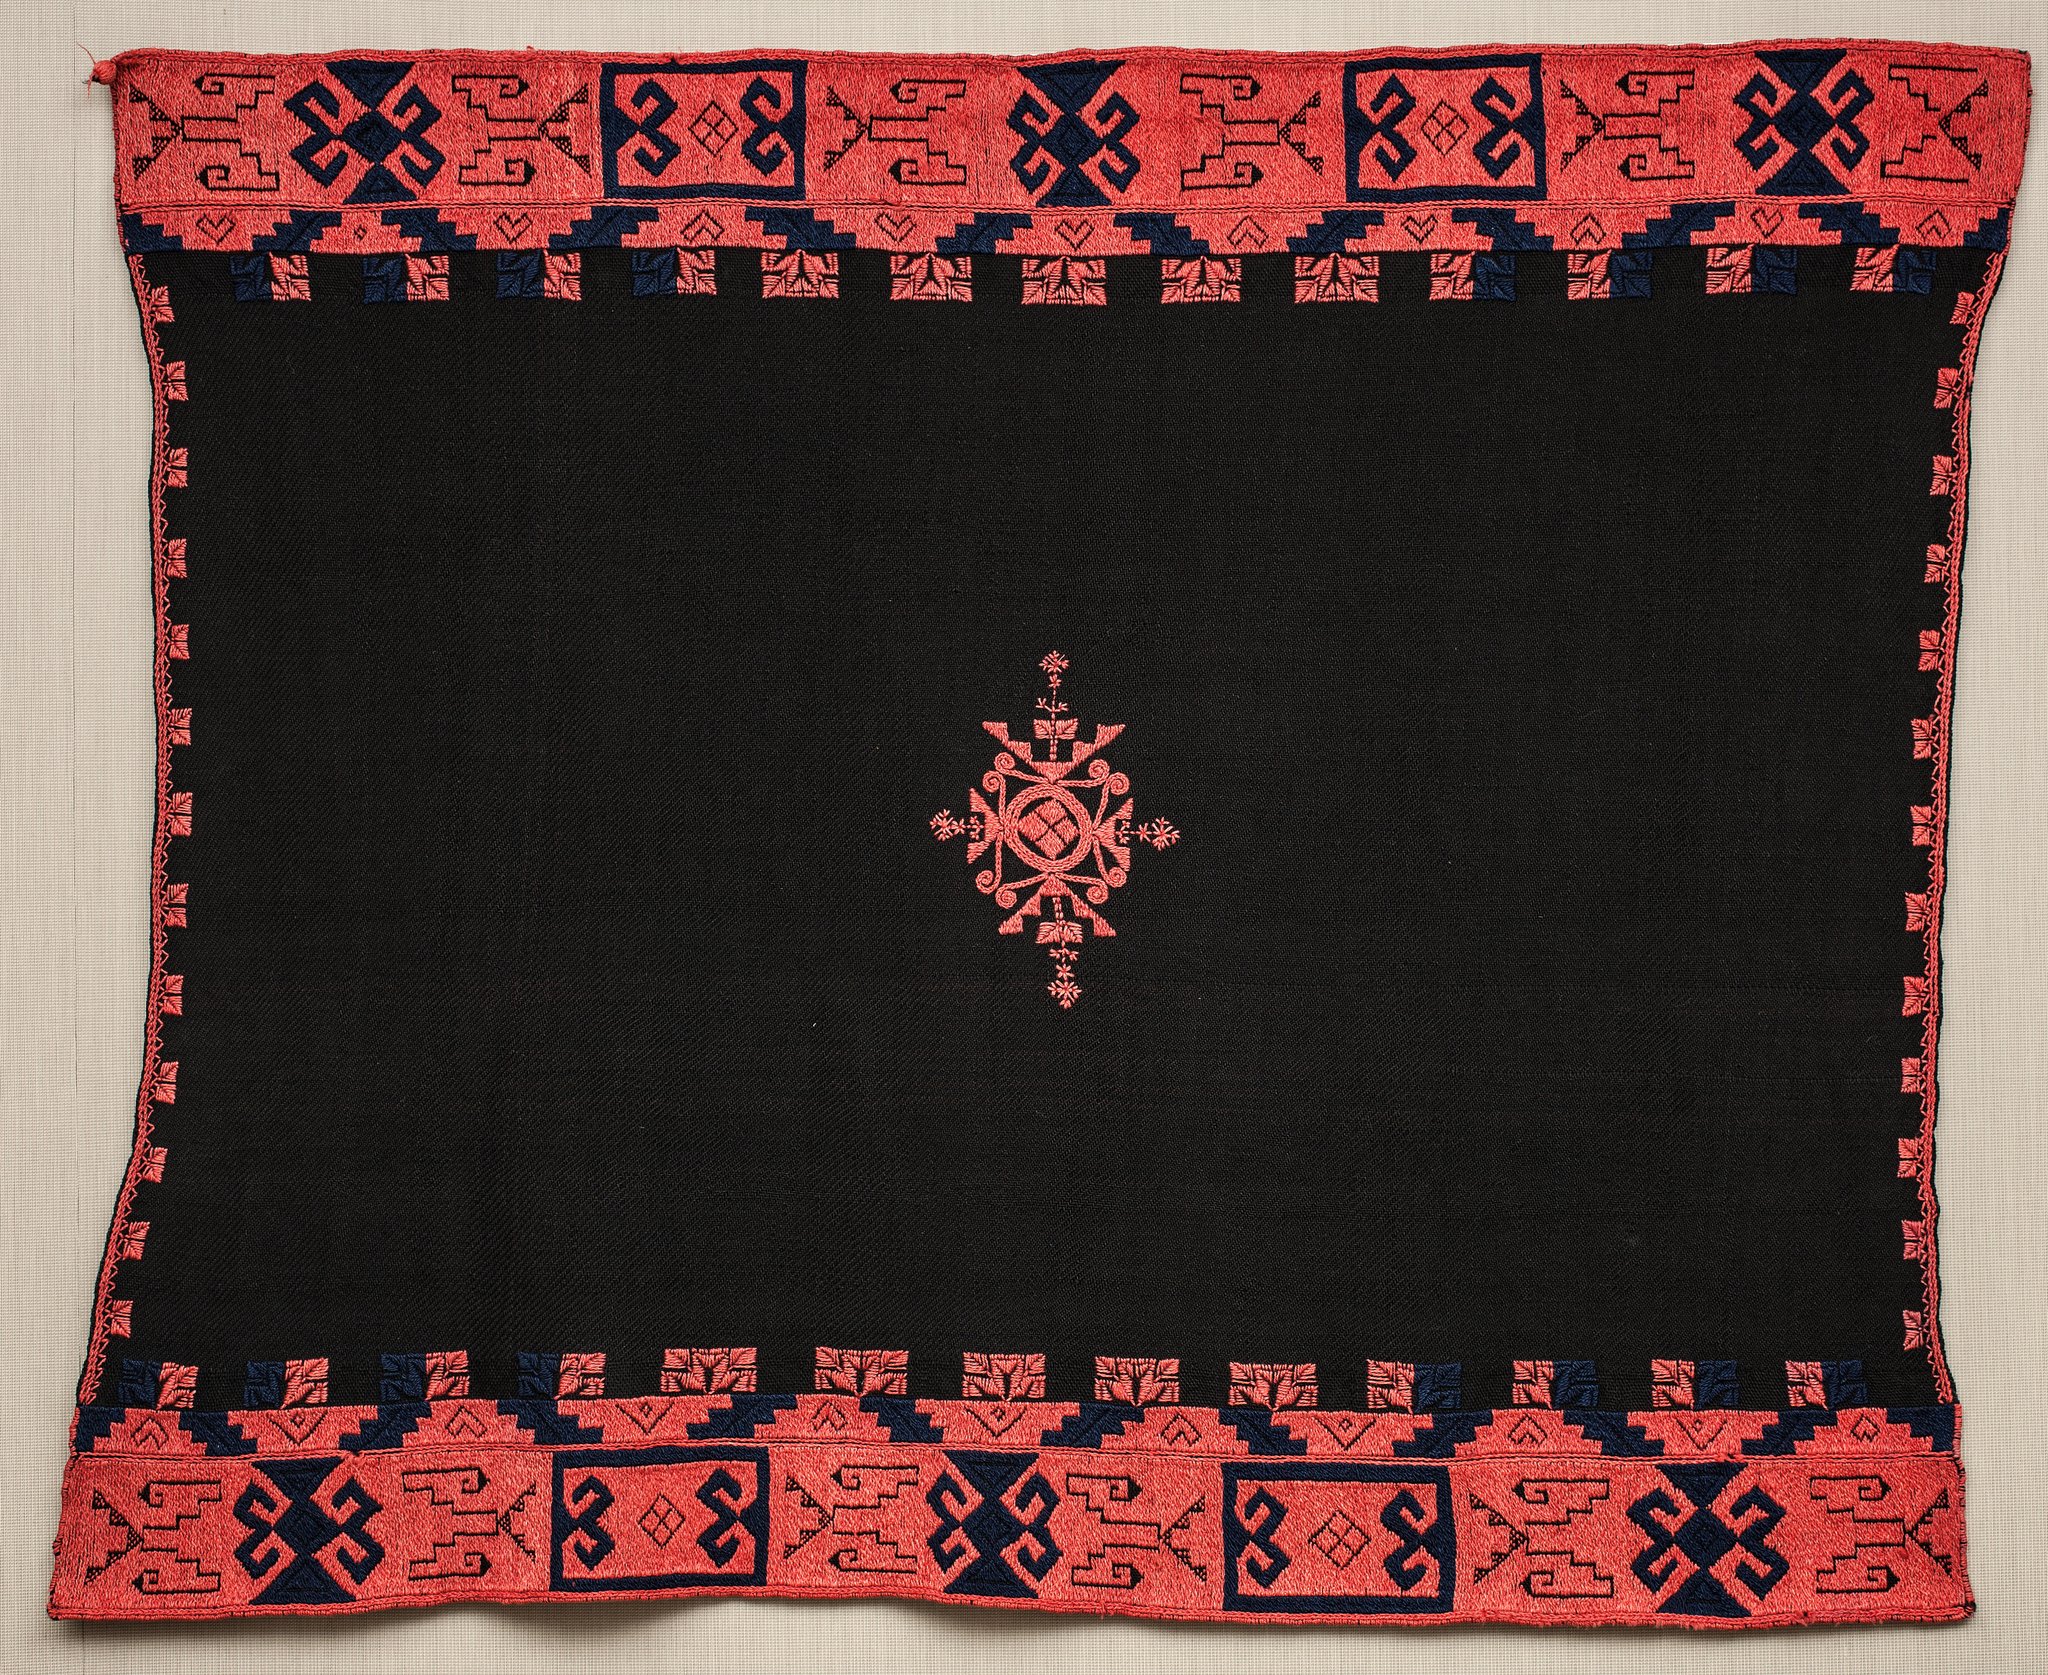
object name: cape or dress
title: Women's Acoma Cape or Dress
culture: acoma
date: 1850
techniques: dyeing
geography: united states